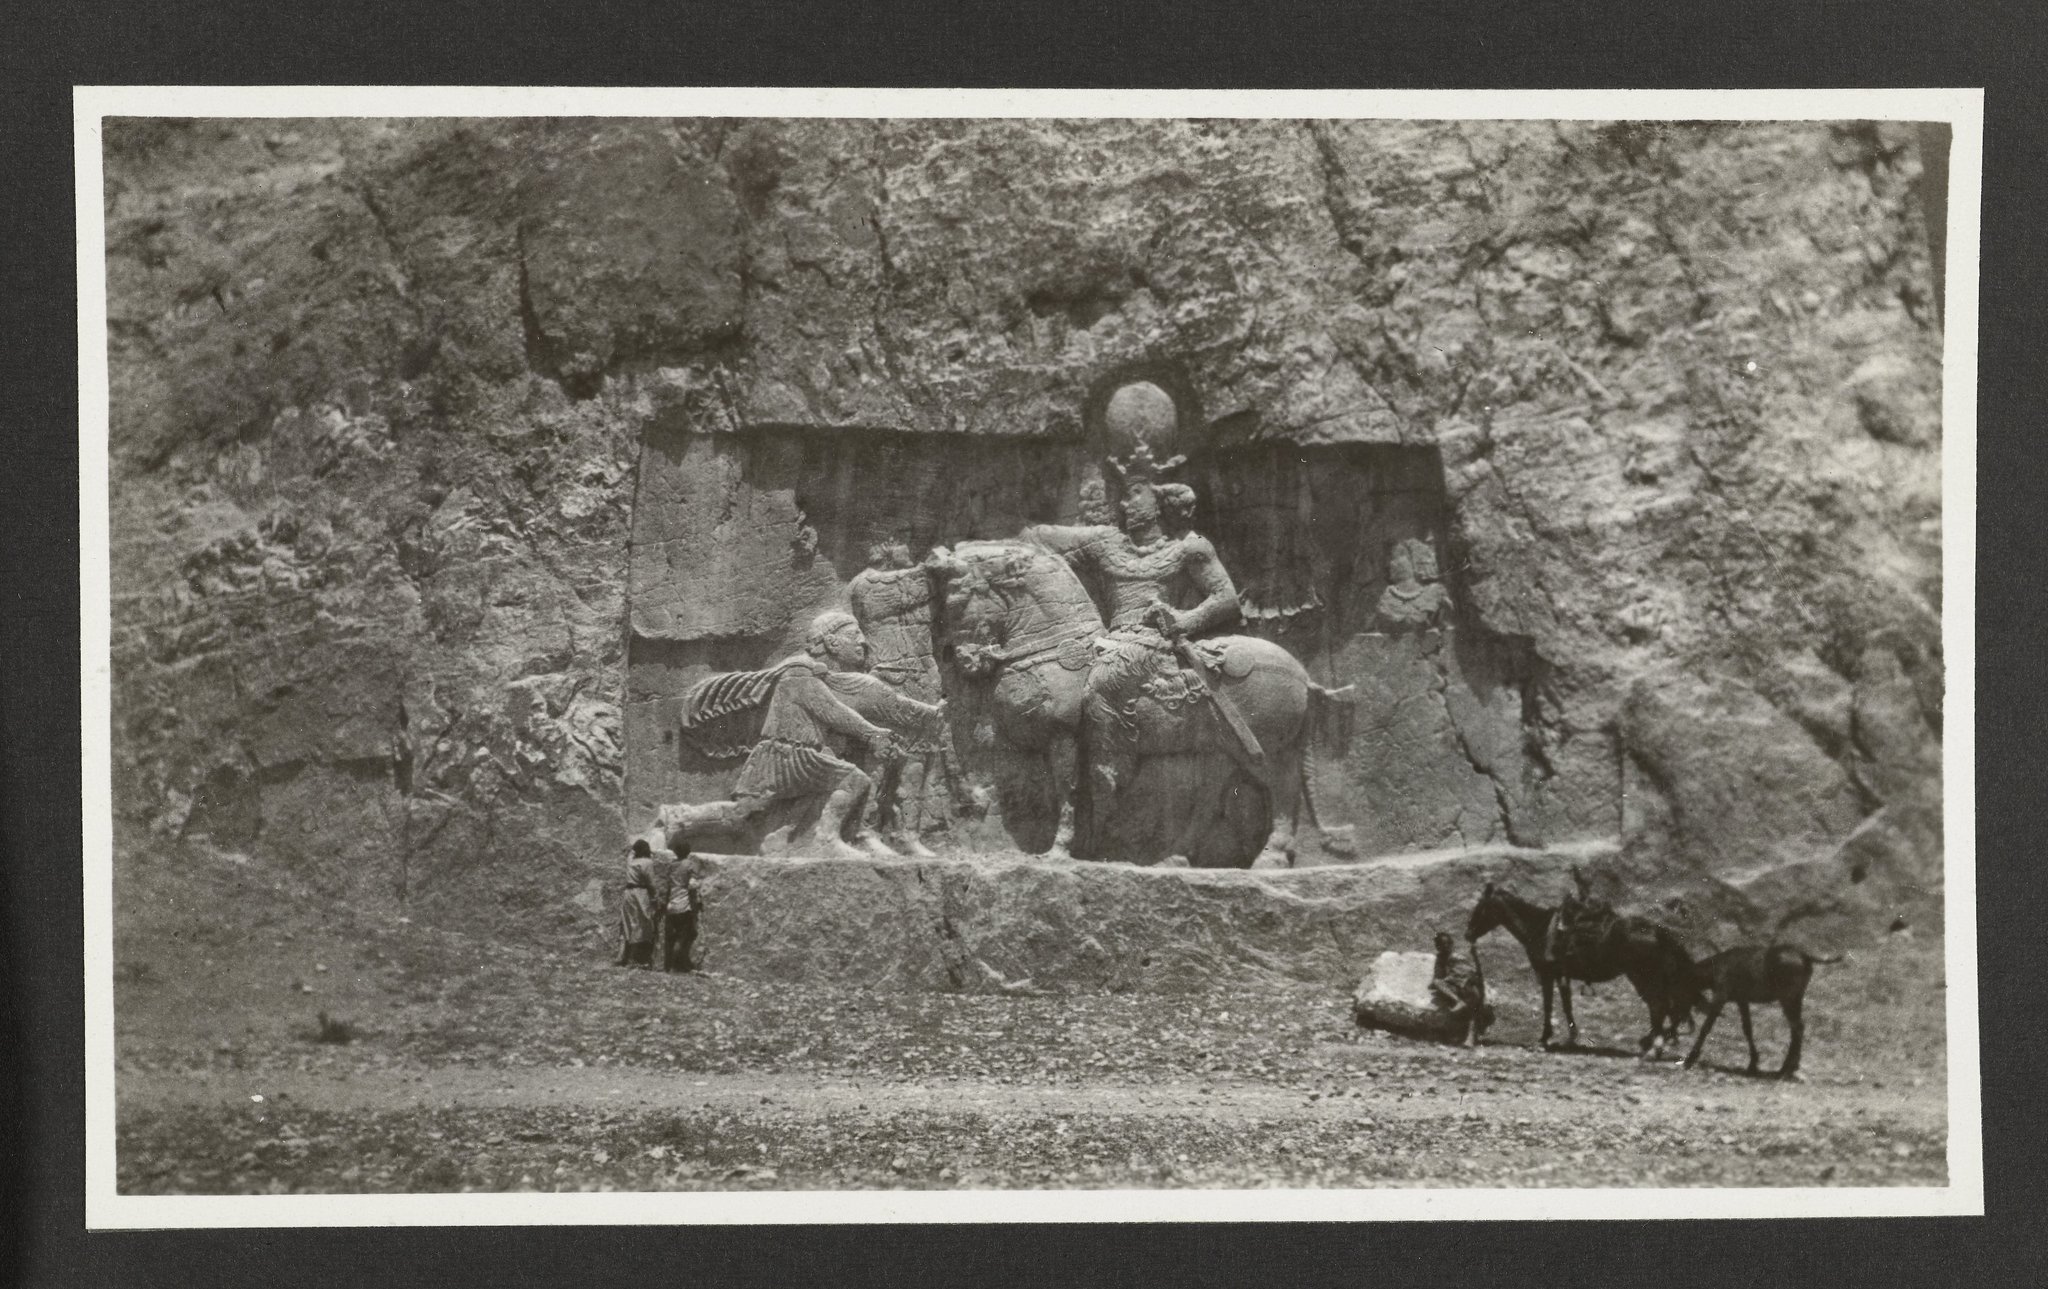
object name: photograph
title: Een steil opgaande rots (ongeveer 1 1/2 uur te paard van het dorp Swansabad), waarin o.a. gehouwen is de op de photo's weergegeven groep, voorstellende de Romeinsche Keizer Valerianus, die, na verslagen en gevangen genomen te zyn, den Perzischen Vorst Shapur (Sapor I) om genade smeekt. (3e eeuw n.C.)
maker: a.g.a. van eelde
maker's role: engineer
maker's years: 1862-1950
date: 1925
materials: cardboard, paper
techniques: gelatin silver print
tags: iran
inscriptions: number: ‘16.’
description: Titel op object afkomstig uit inventaris (Verklaring der Photo's) behorend bij het album.